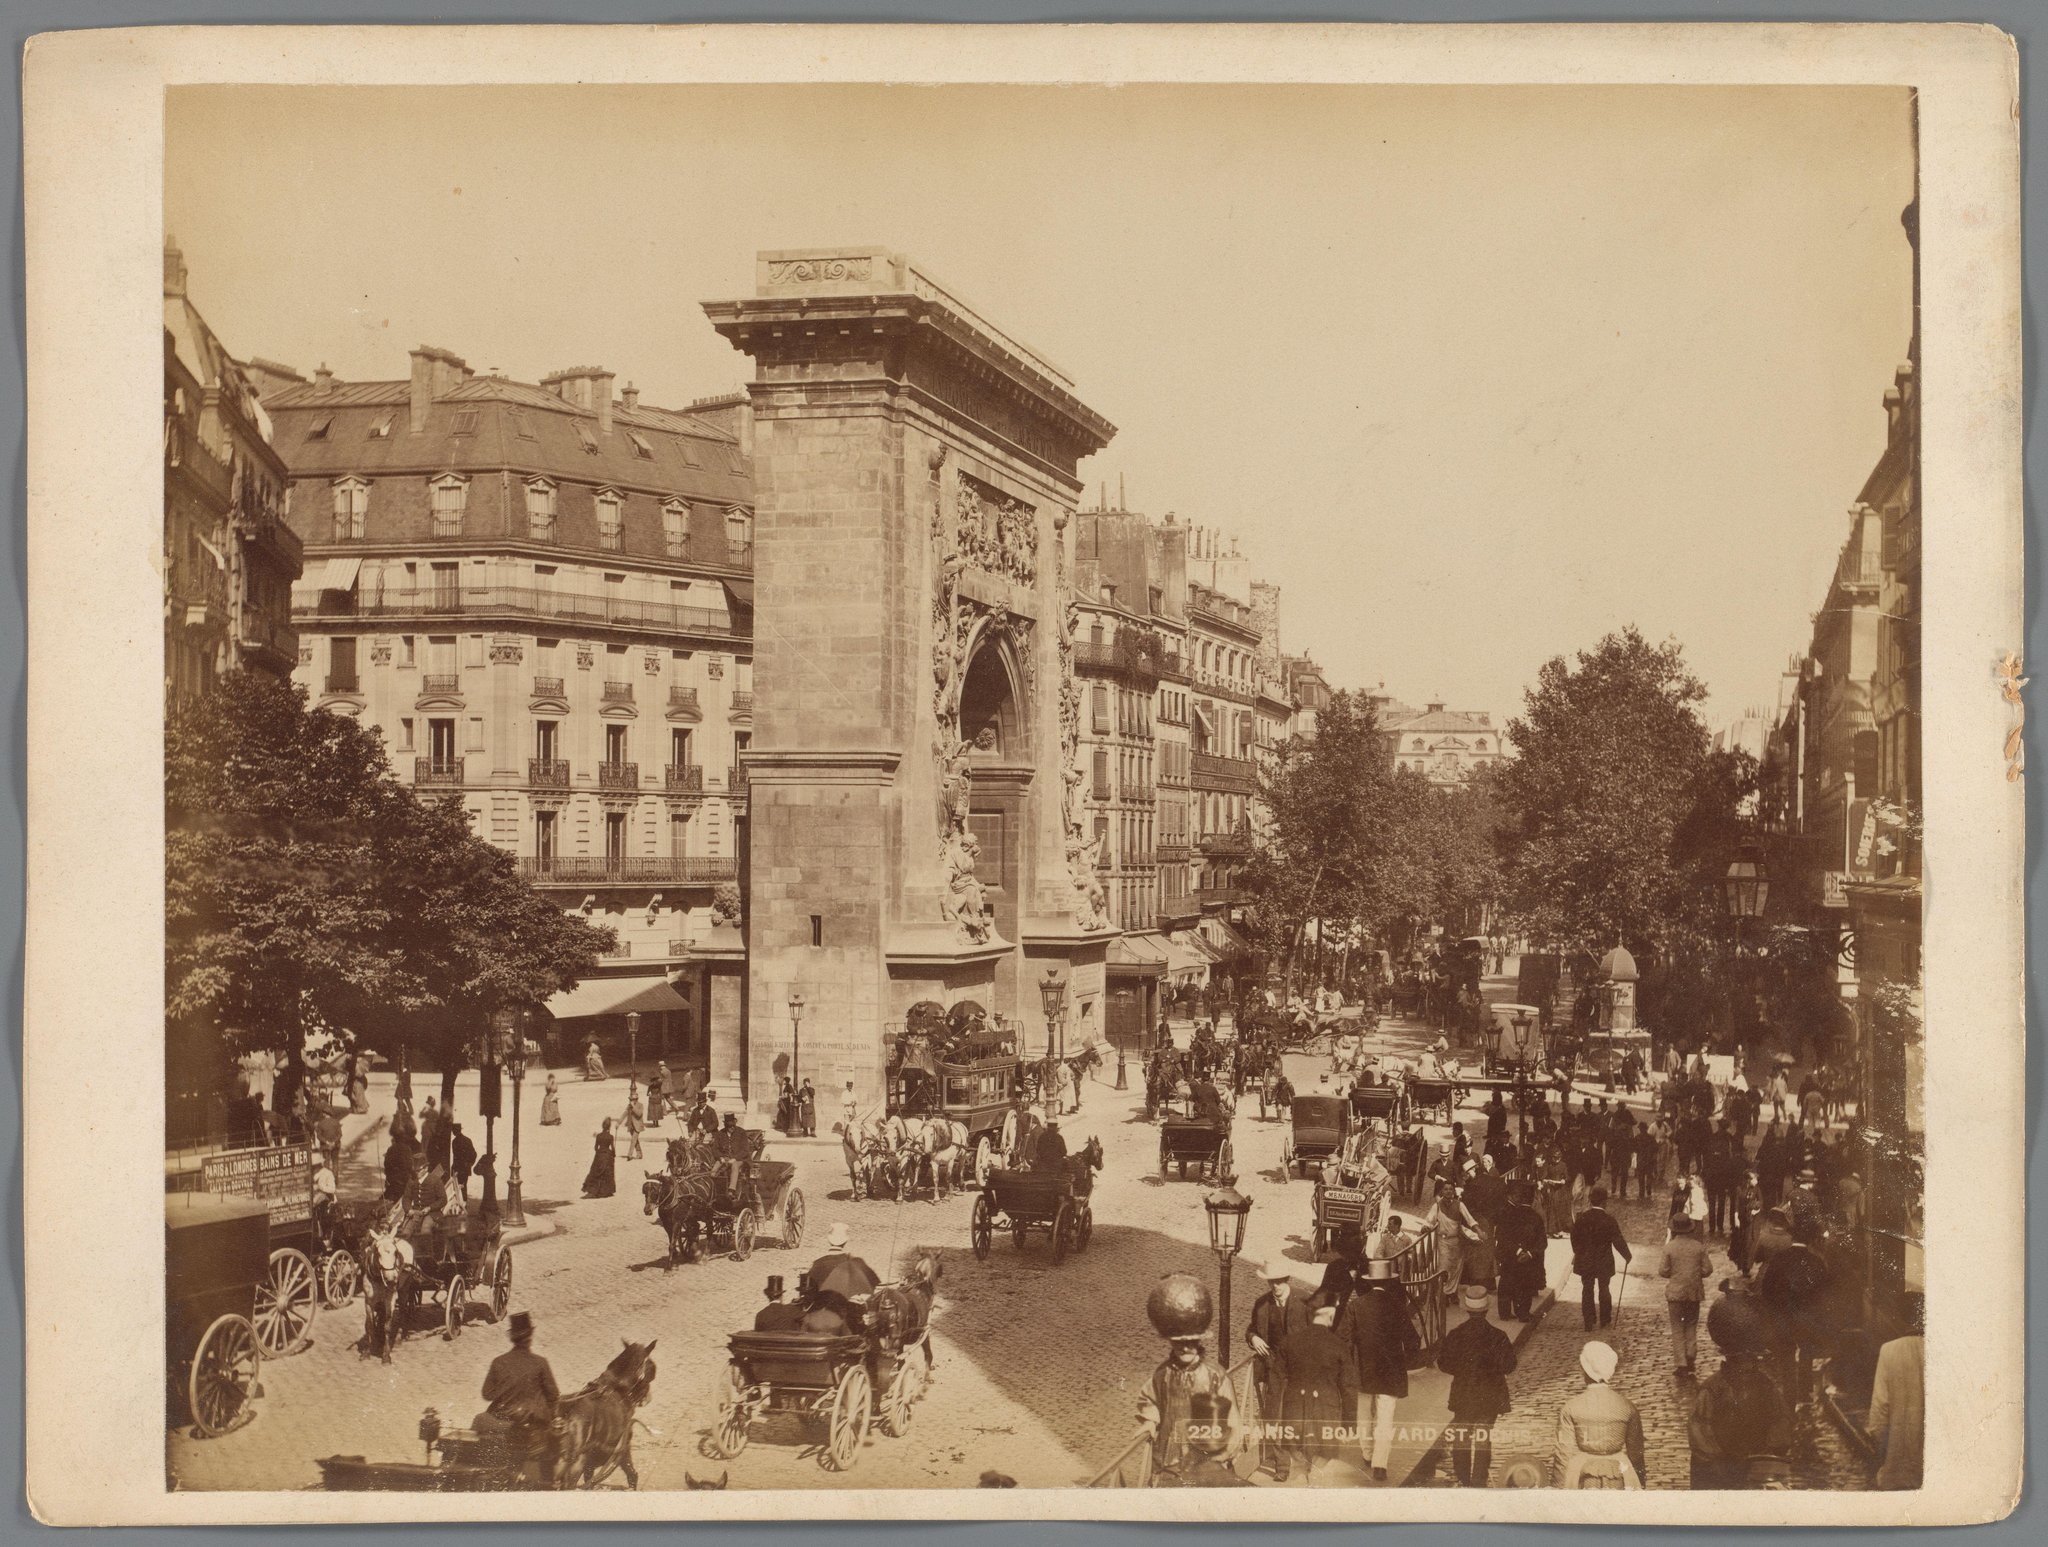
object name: photograph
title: Paris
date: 1864-1895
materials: cardboard, paper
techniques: albumen print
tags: crowd, mob, triumphal arch, avenue, boulevard, promenade, esplanade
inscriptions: number: ‘228.’